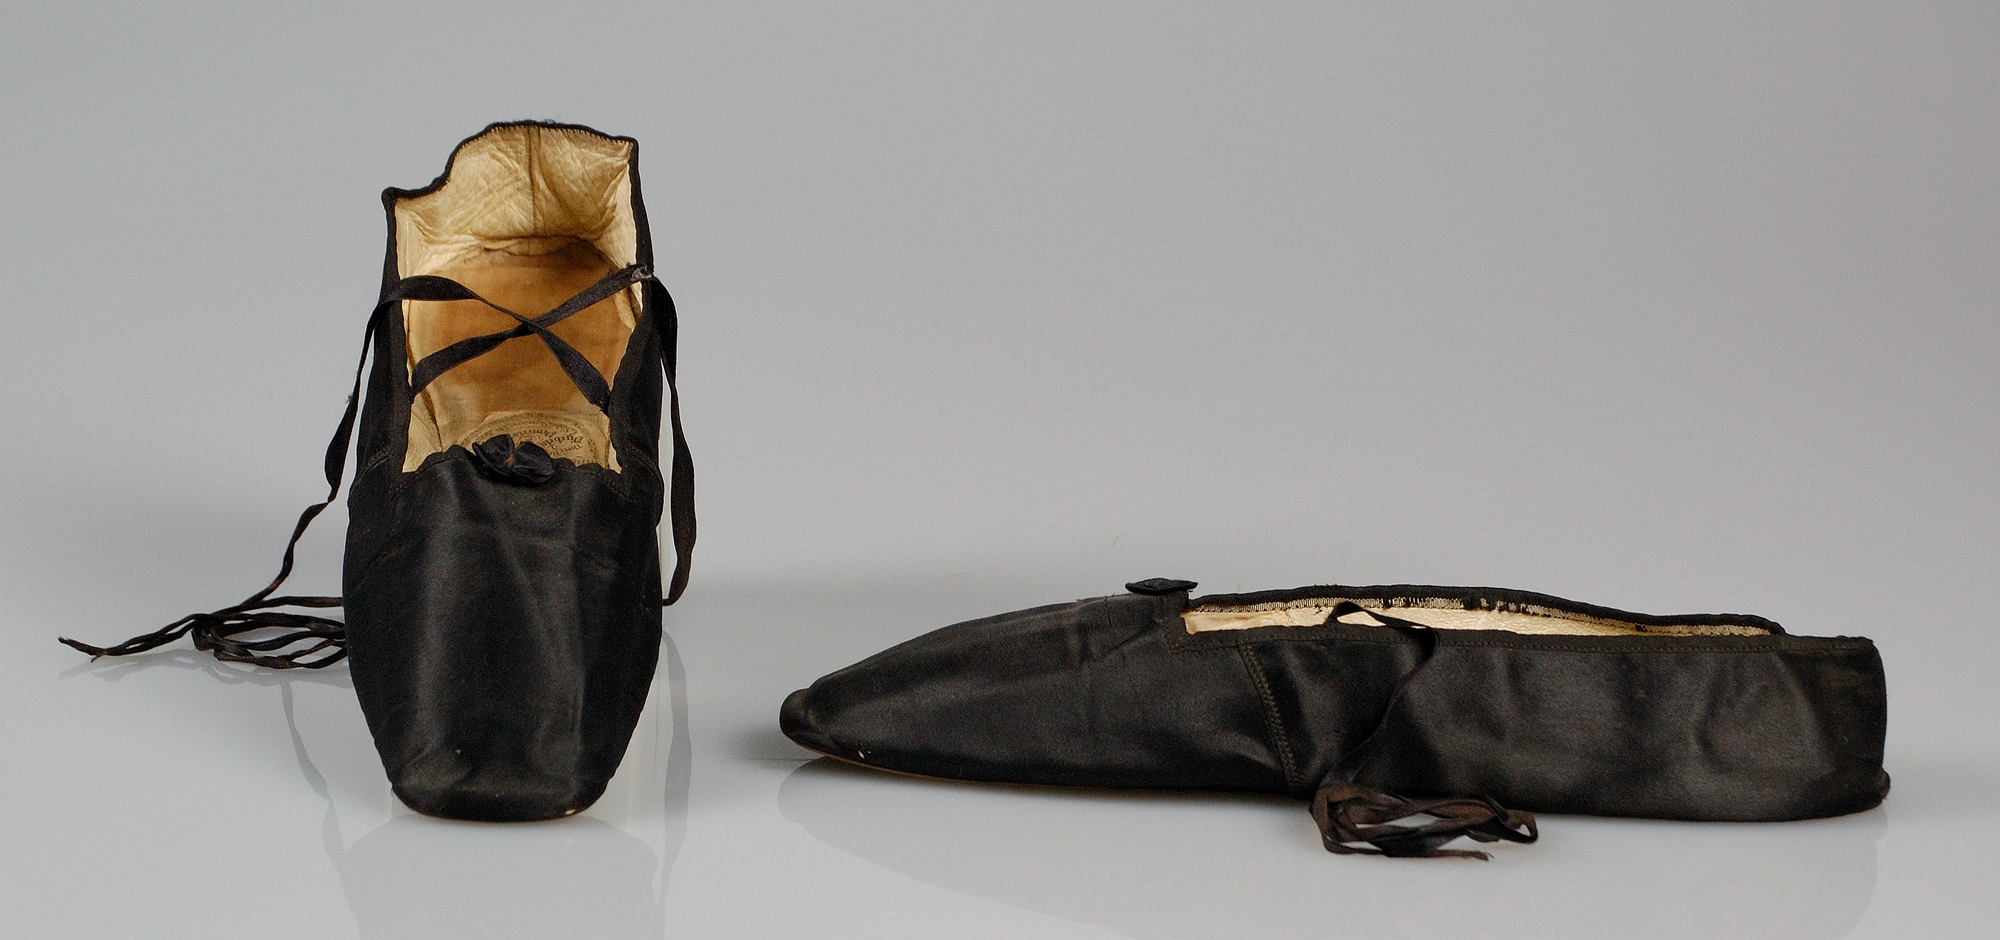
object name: evening slipper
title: Evening slippers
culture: british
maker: gundry & sons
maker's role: designer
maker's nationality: british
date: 1845-1865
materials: silk